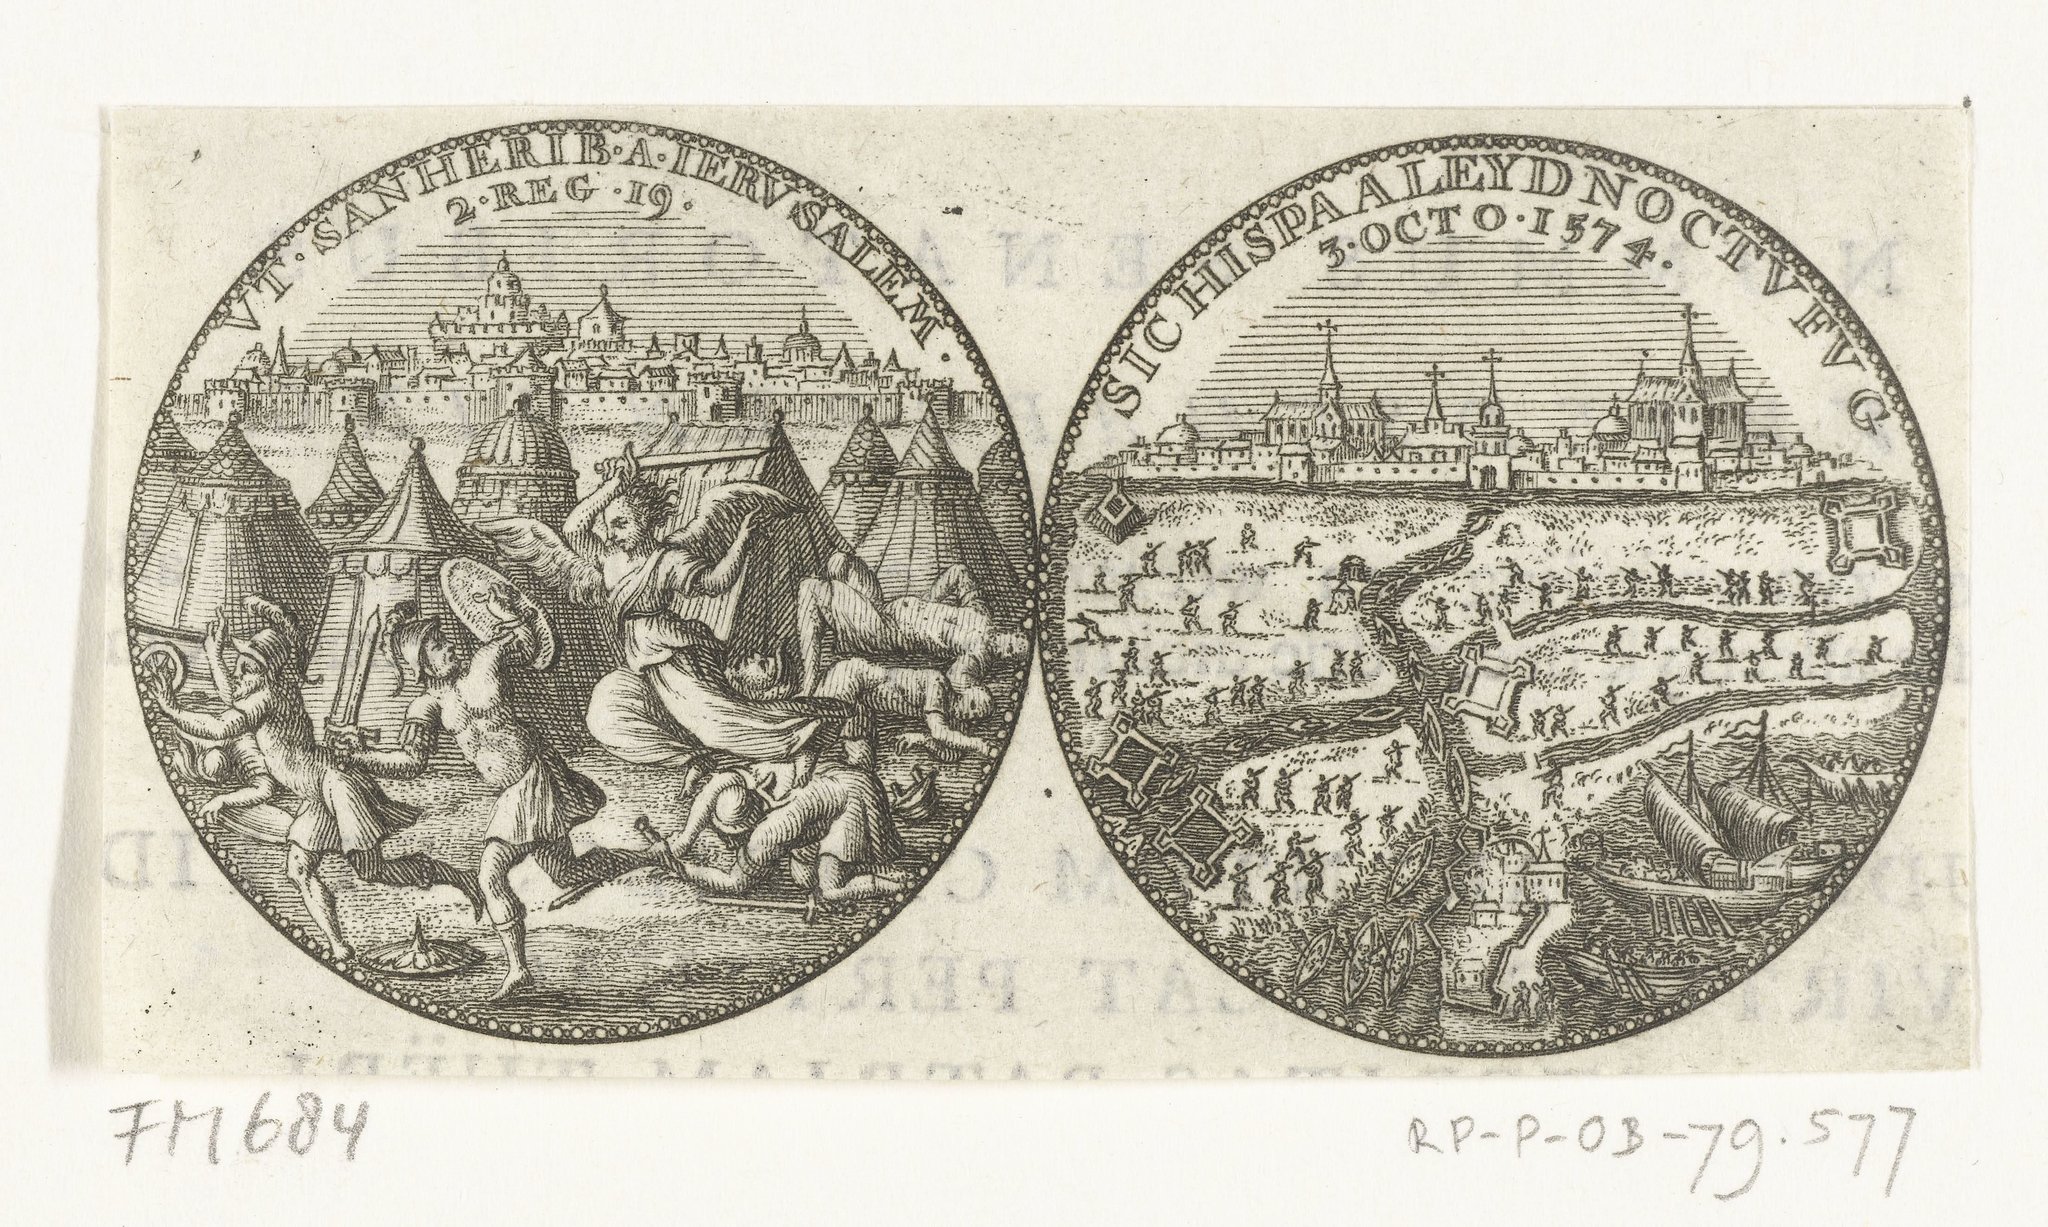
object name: print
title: Penning op het ontzet van Leiden, 1574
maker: Anonymous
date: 1721-1723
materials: paper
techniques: etching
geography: northern netherlands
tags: at night, an angel of the lord decimates the assyrian camp: 185.000 soldiers are killed, medal (considered as a piece of sculpture, regardless of its specific function), leiden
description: Penning op het ontzet van Leiden, 1574. Bedrukt op achterzijde met tekst in het Latijn en Nederlands. Zilveren penning. Voorzijde: beleg van Jeruzalem door de koning van Assyrië, wiens soldaten uit tentenkamp vluchten voor een engel met getrokken zwaard binnen omschrift. Keerzijde: gezicht op stad Leiden boven plattegrond met vestingwerken en aftocht van belegeraars binnen omschrift.